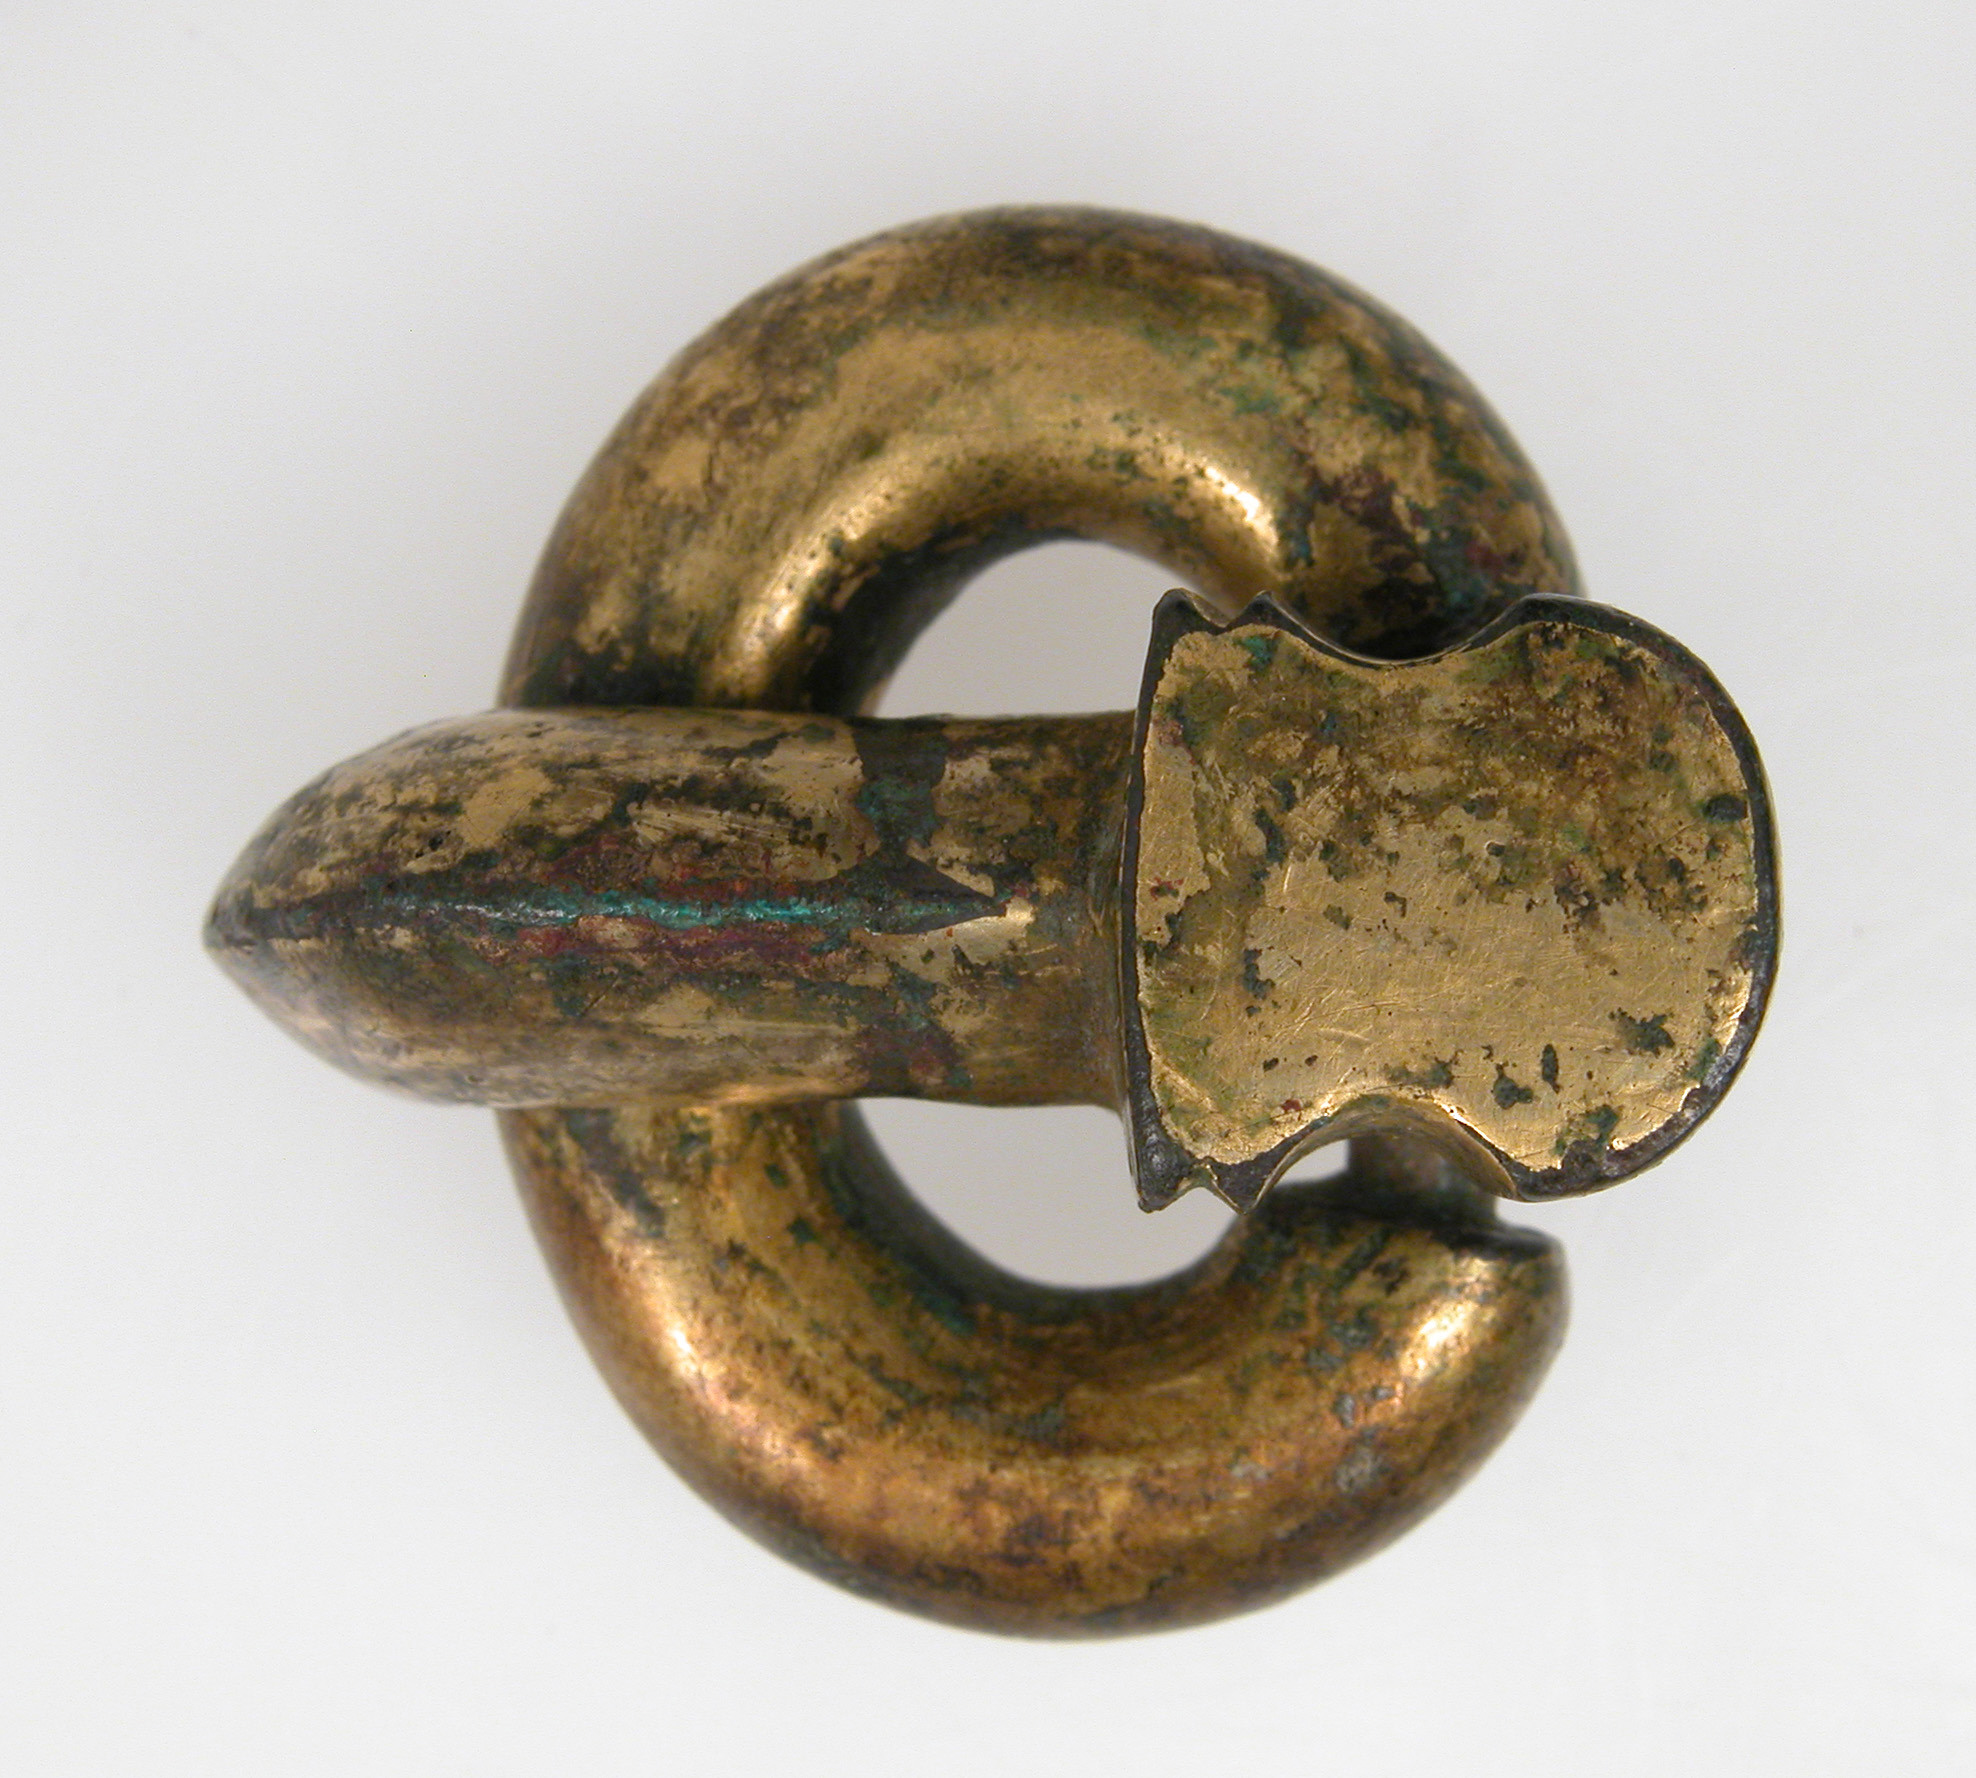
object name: buckle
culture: frankish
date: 601-700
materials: bronze, gilt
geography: northern france